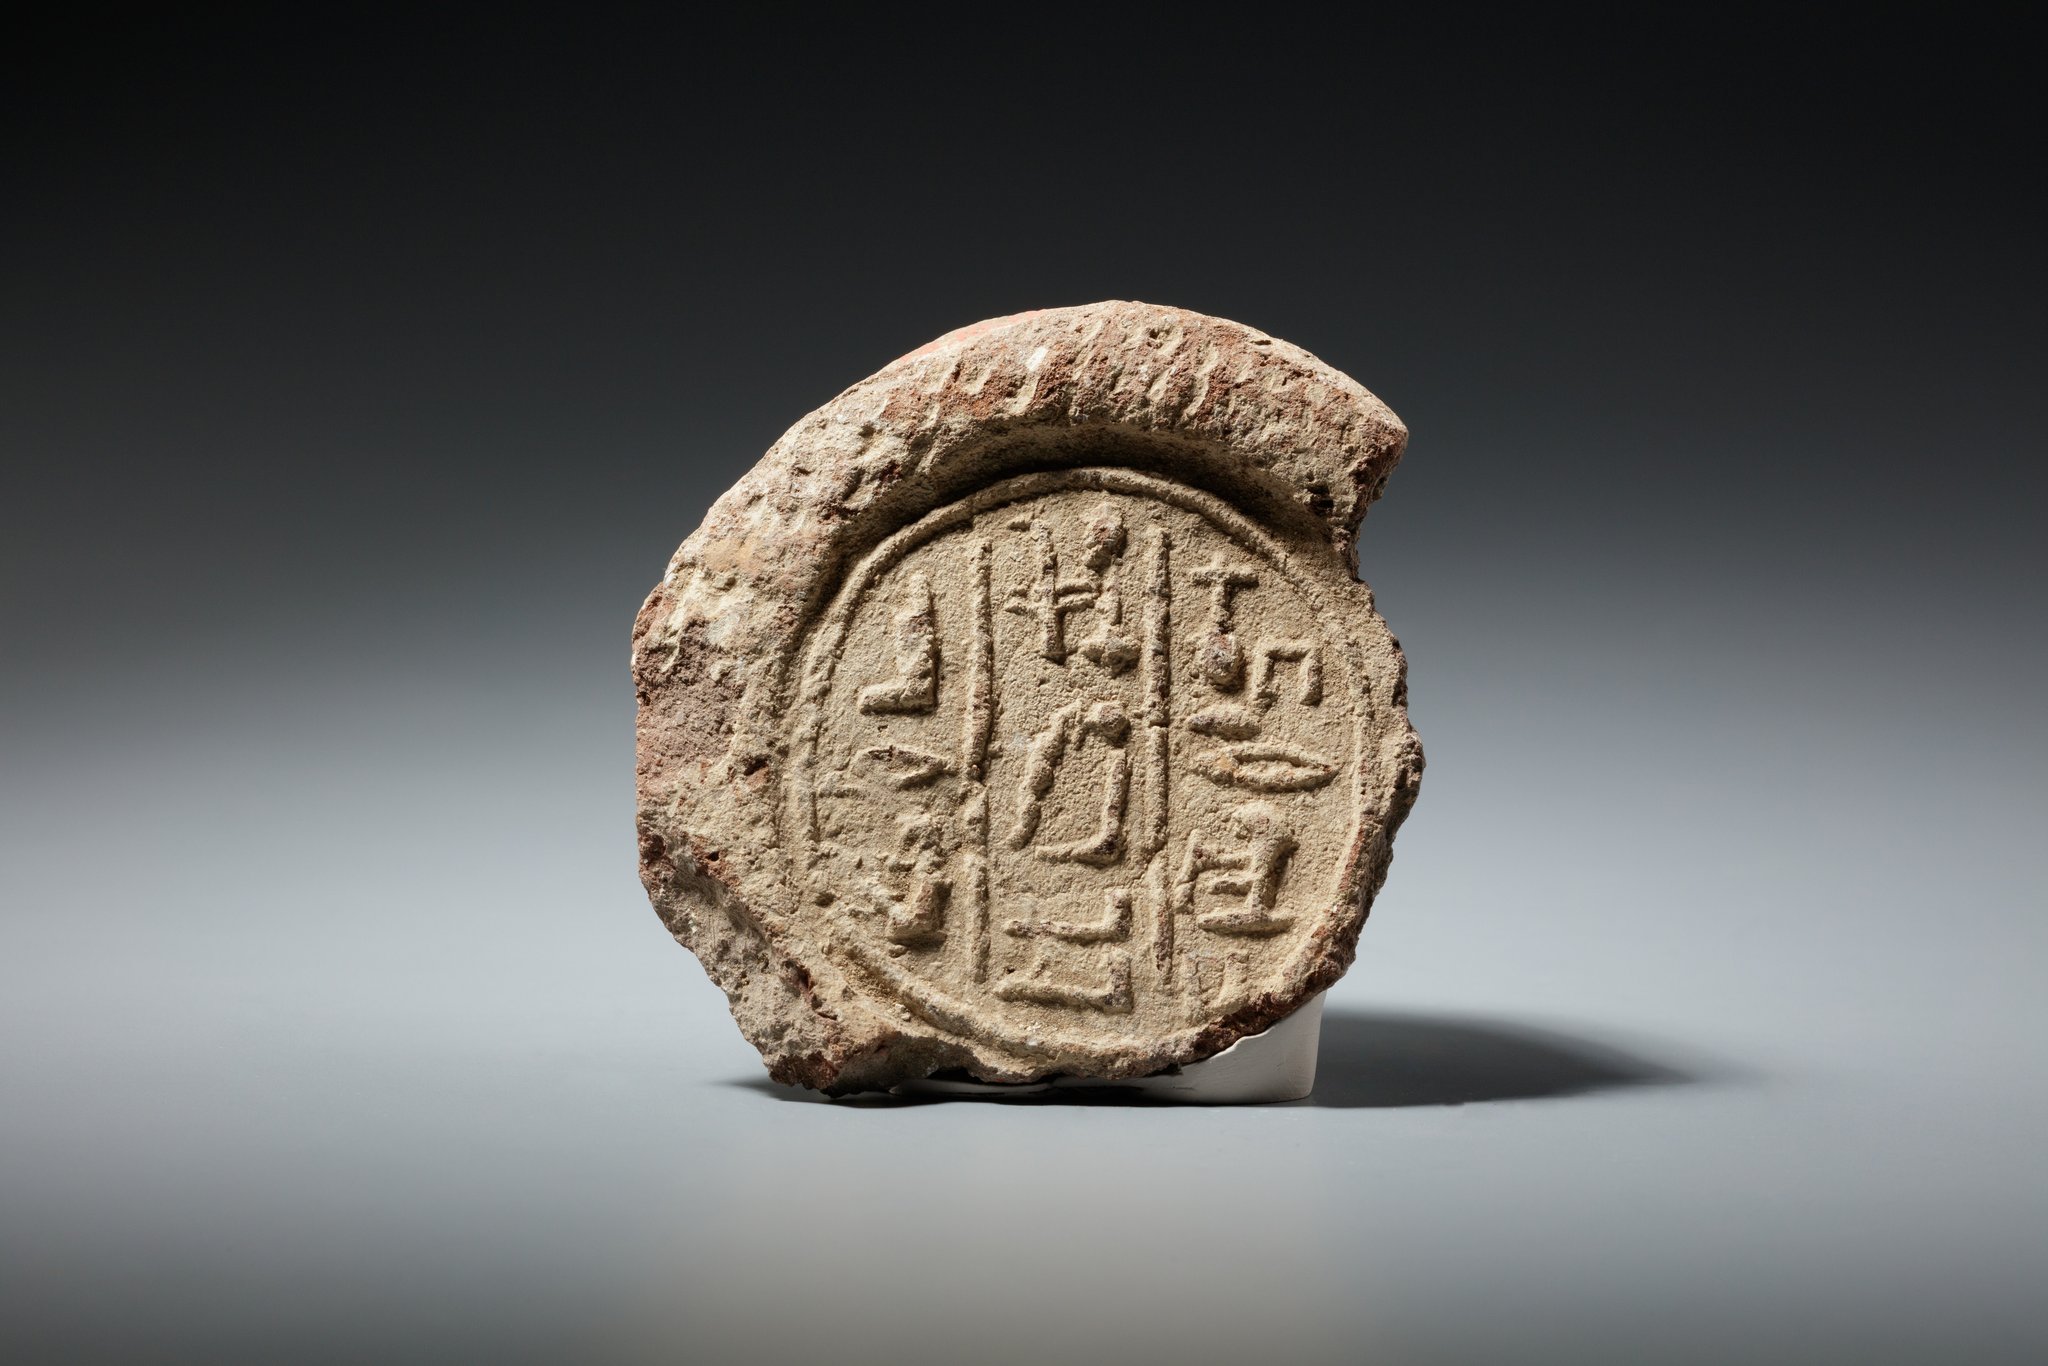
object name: cone, davy 213, neferperet, cup bearer, king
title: Funerary Cone of the Cup-Bearer Neferperet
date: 1550-1295 BCE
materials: pottery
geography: egypt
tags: hieroglyphs